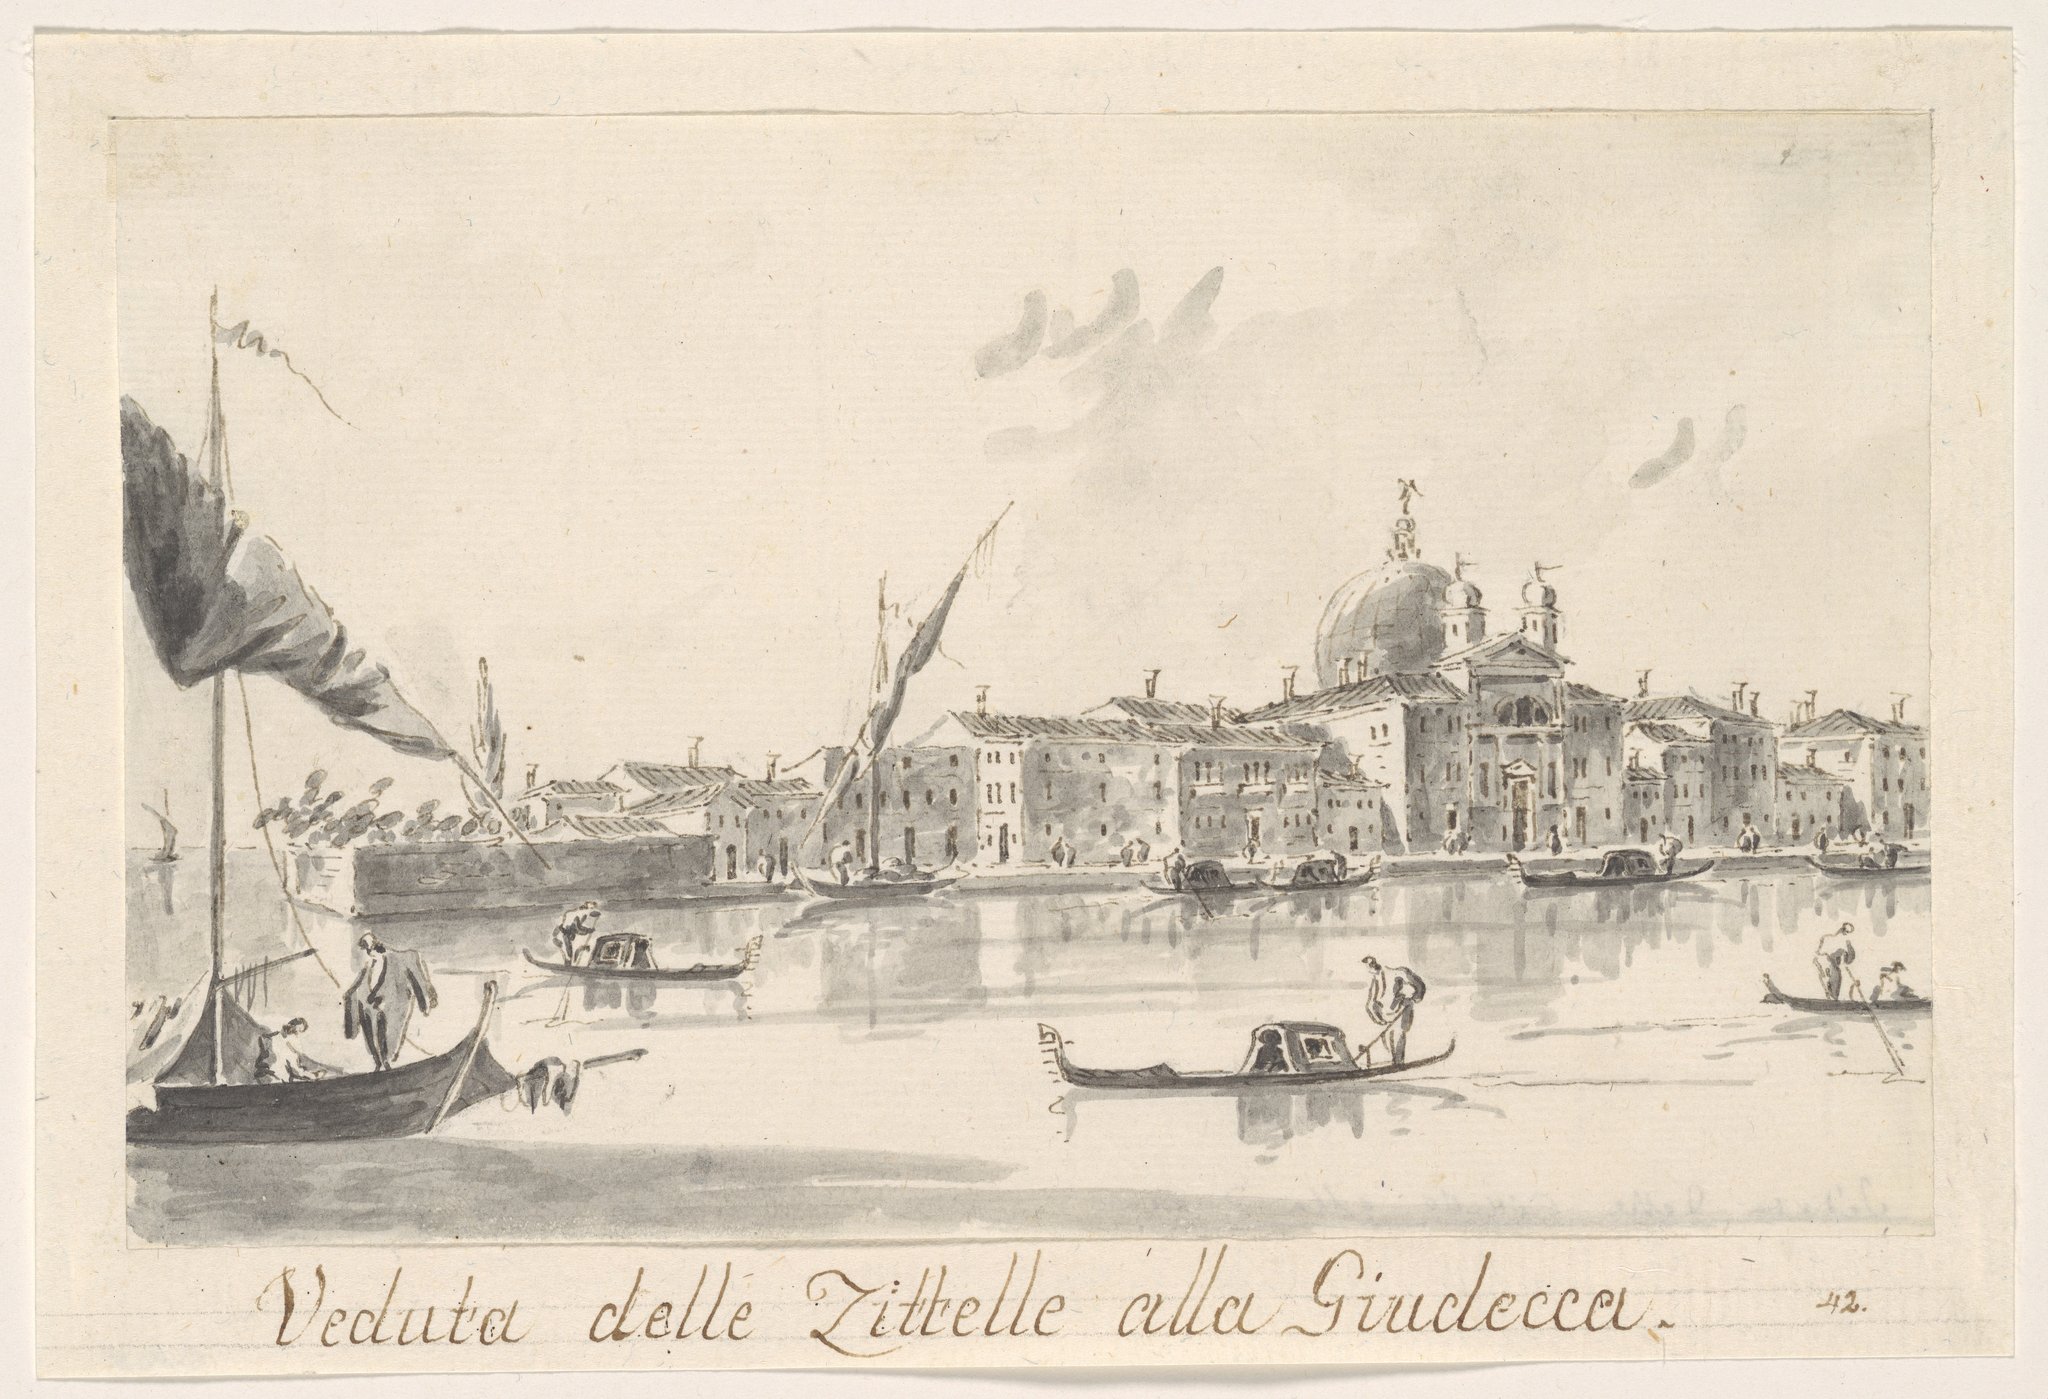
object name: drawing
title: The Church of the Zitelle on the Giudecca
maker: giacomo guardi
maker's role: artist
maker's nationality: italian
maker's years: 1764-1835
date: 1804-1828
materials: ink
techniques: pen, wash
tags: churches,boats